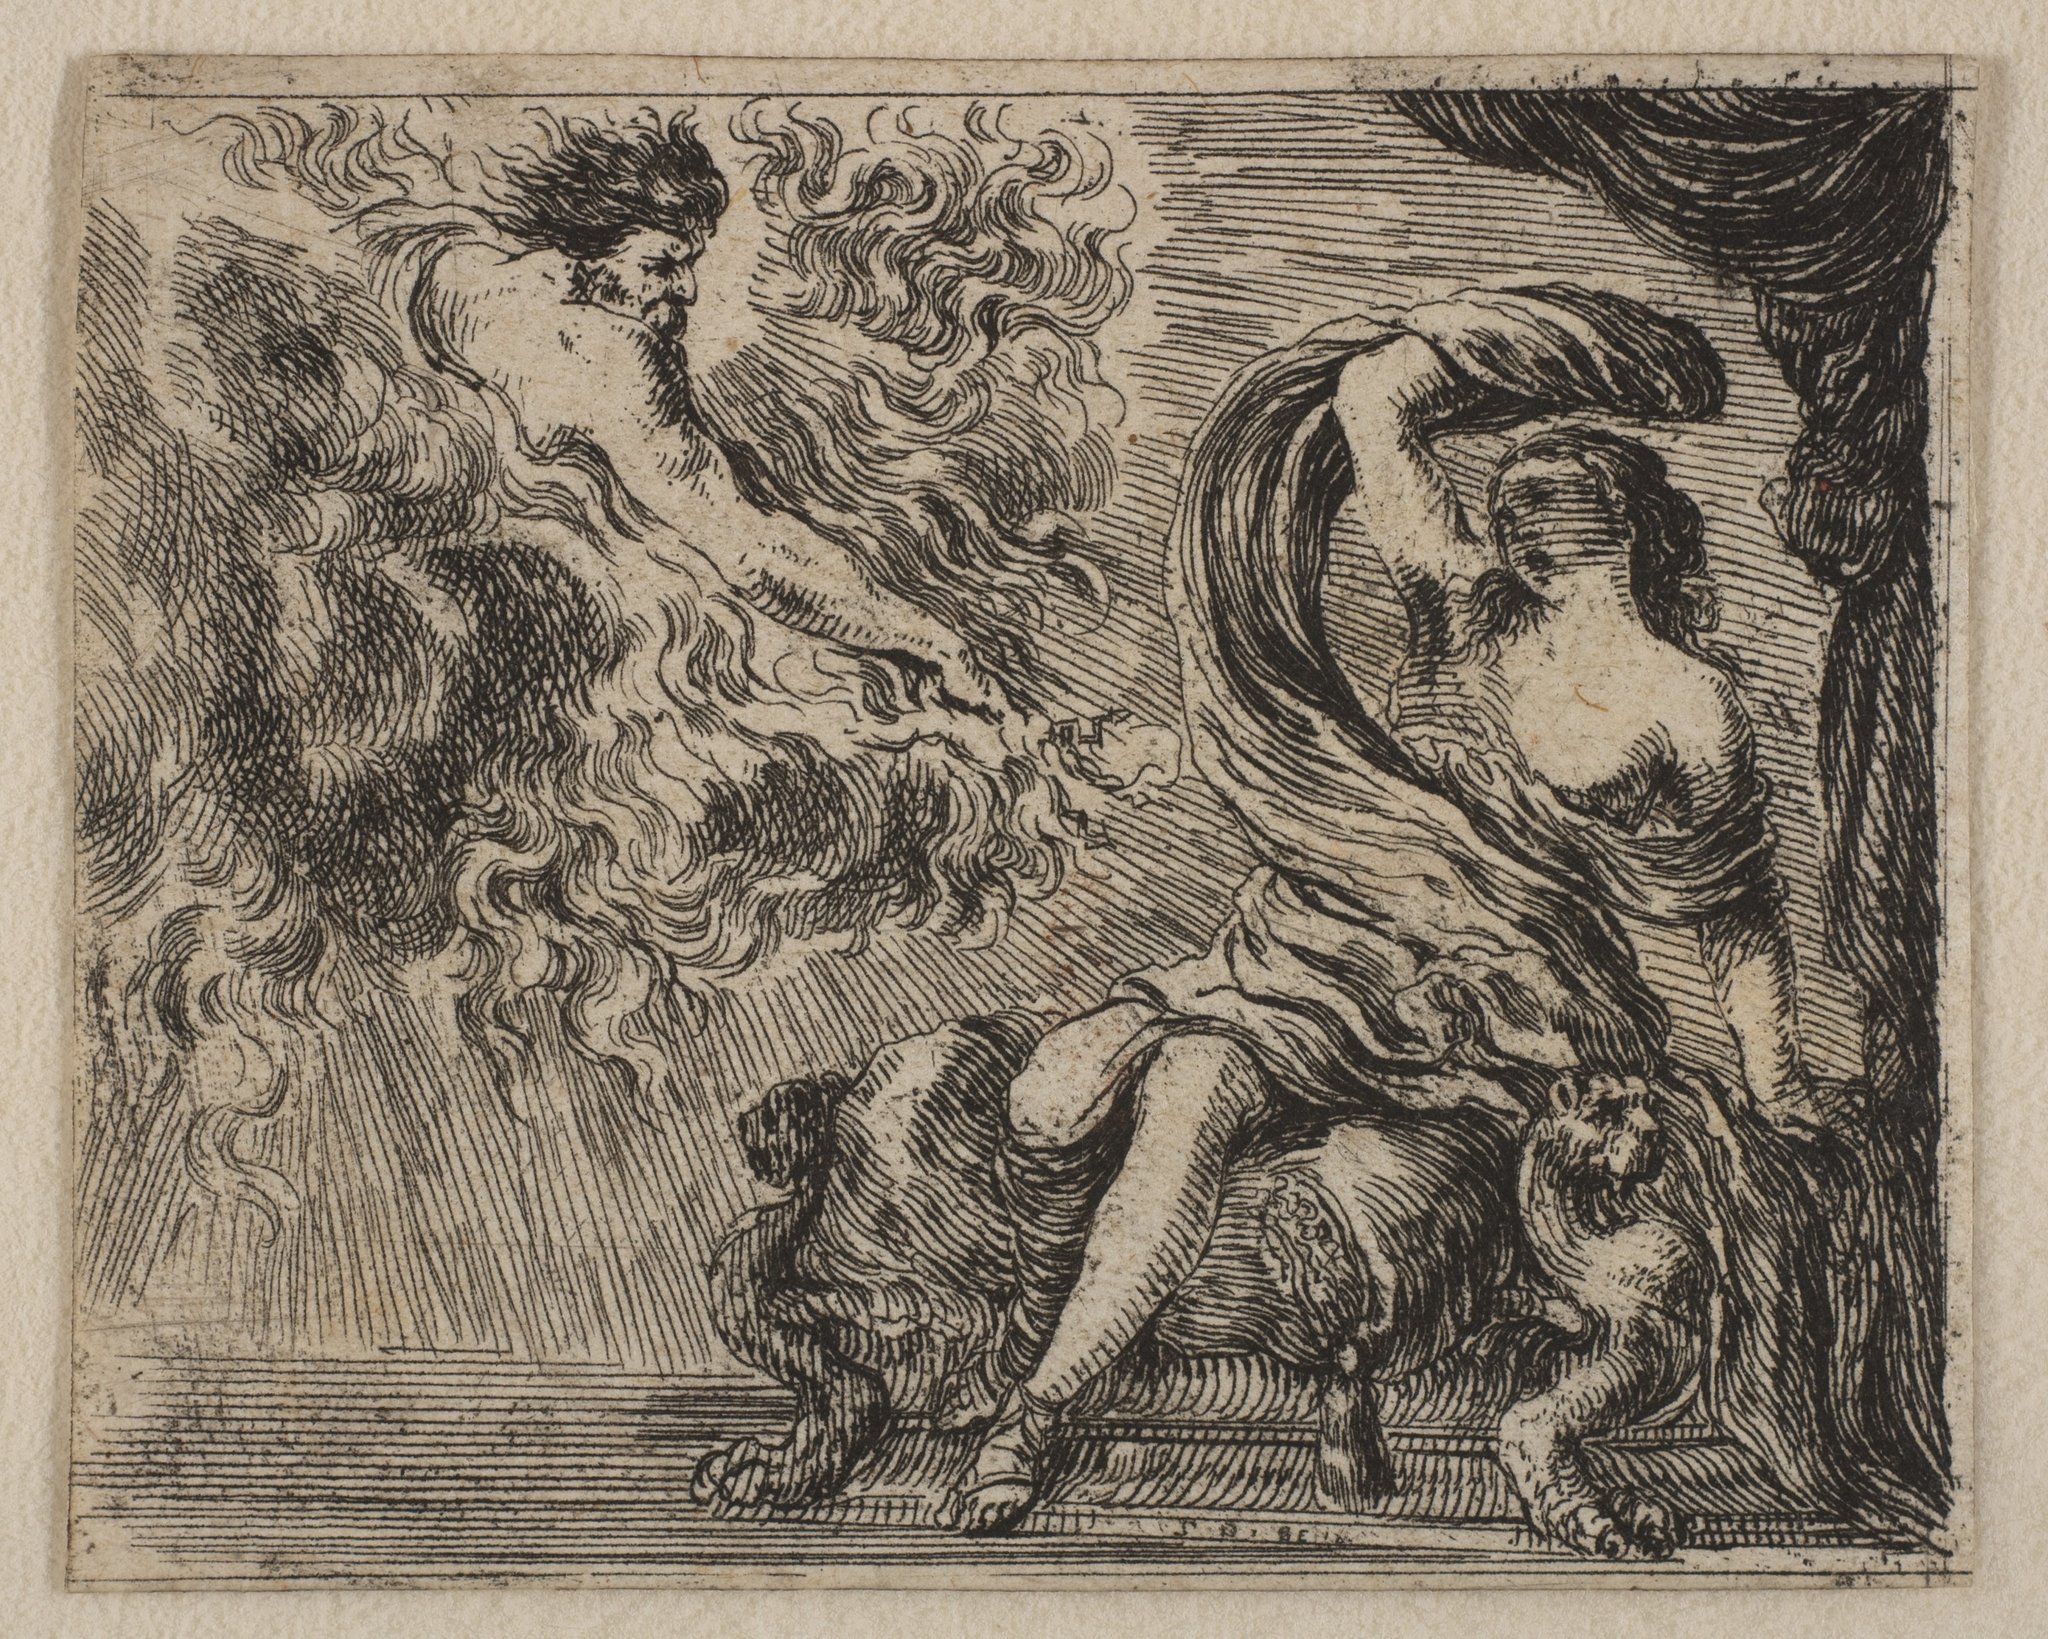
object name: print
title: Jupiter and Semele, from 'Game of Mythology' (Jeu de la Mythologie)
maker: stefano della bella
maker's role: artist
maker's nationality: italian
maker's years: 1610-1664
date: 1644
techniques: etching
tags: women,jupiter